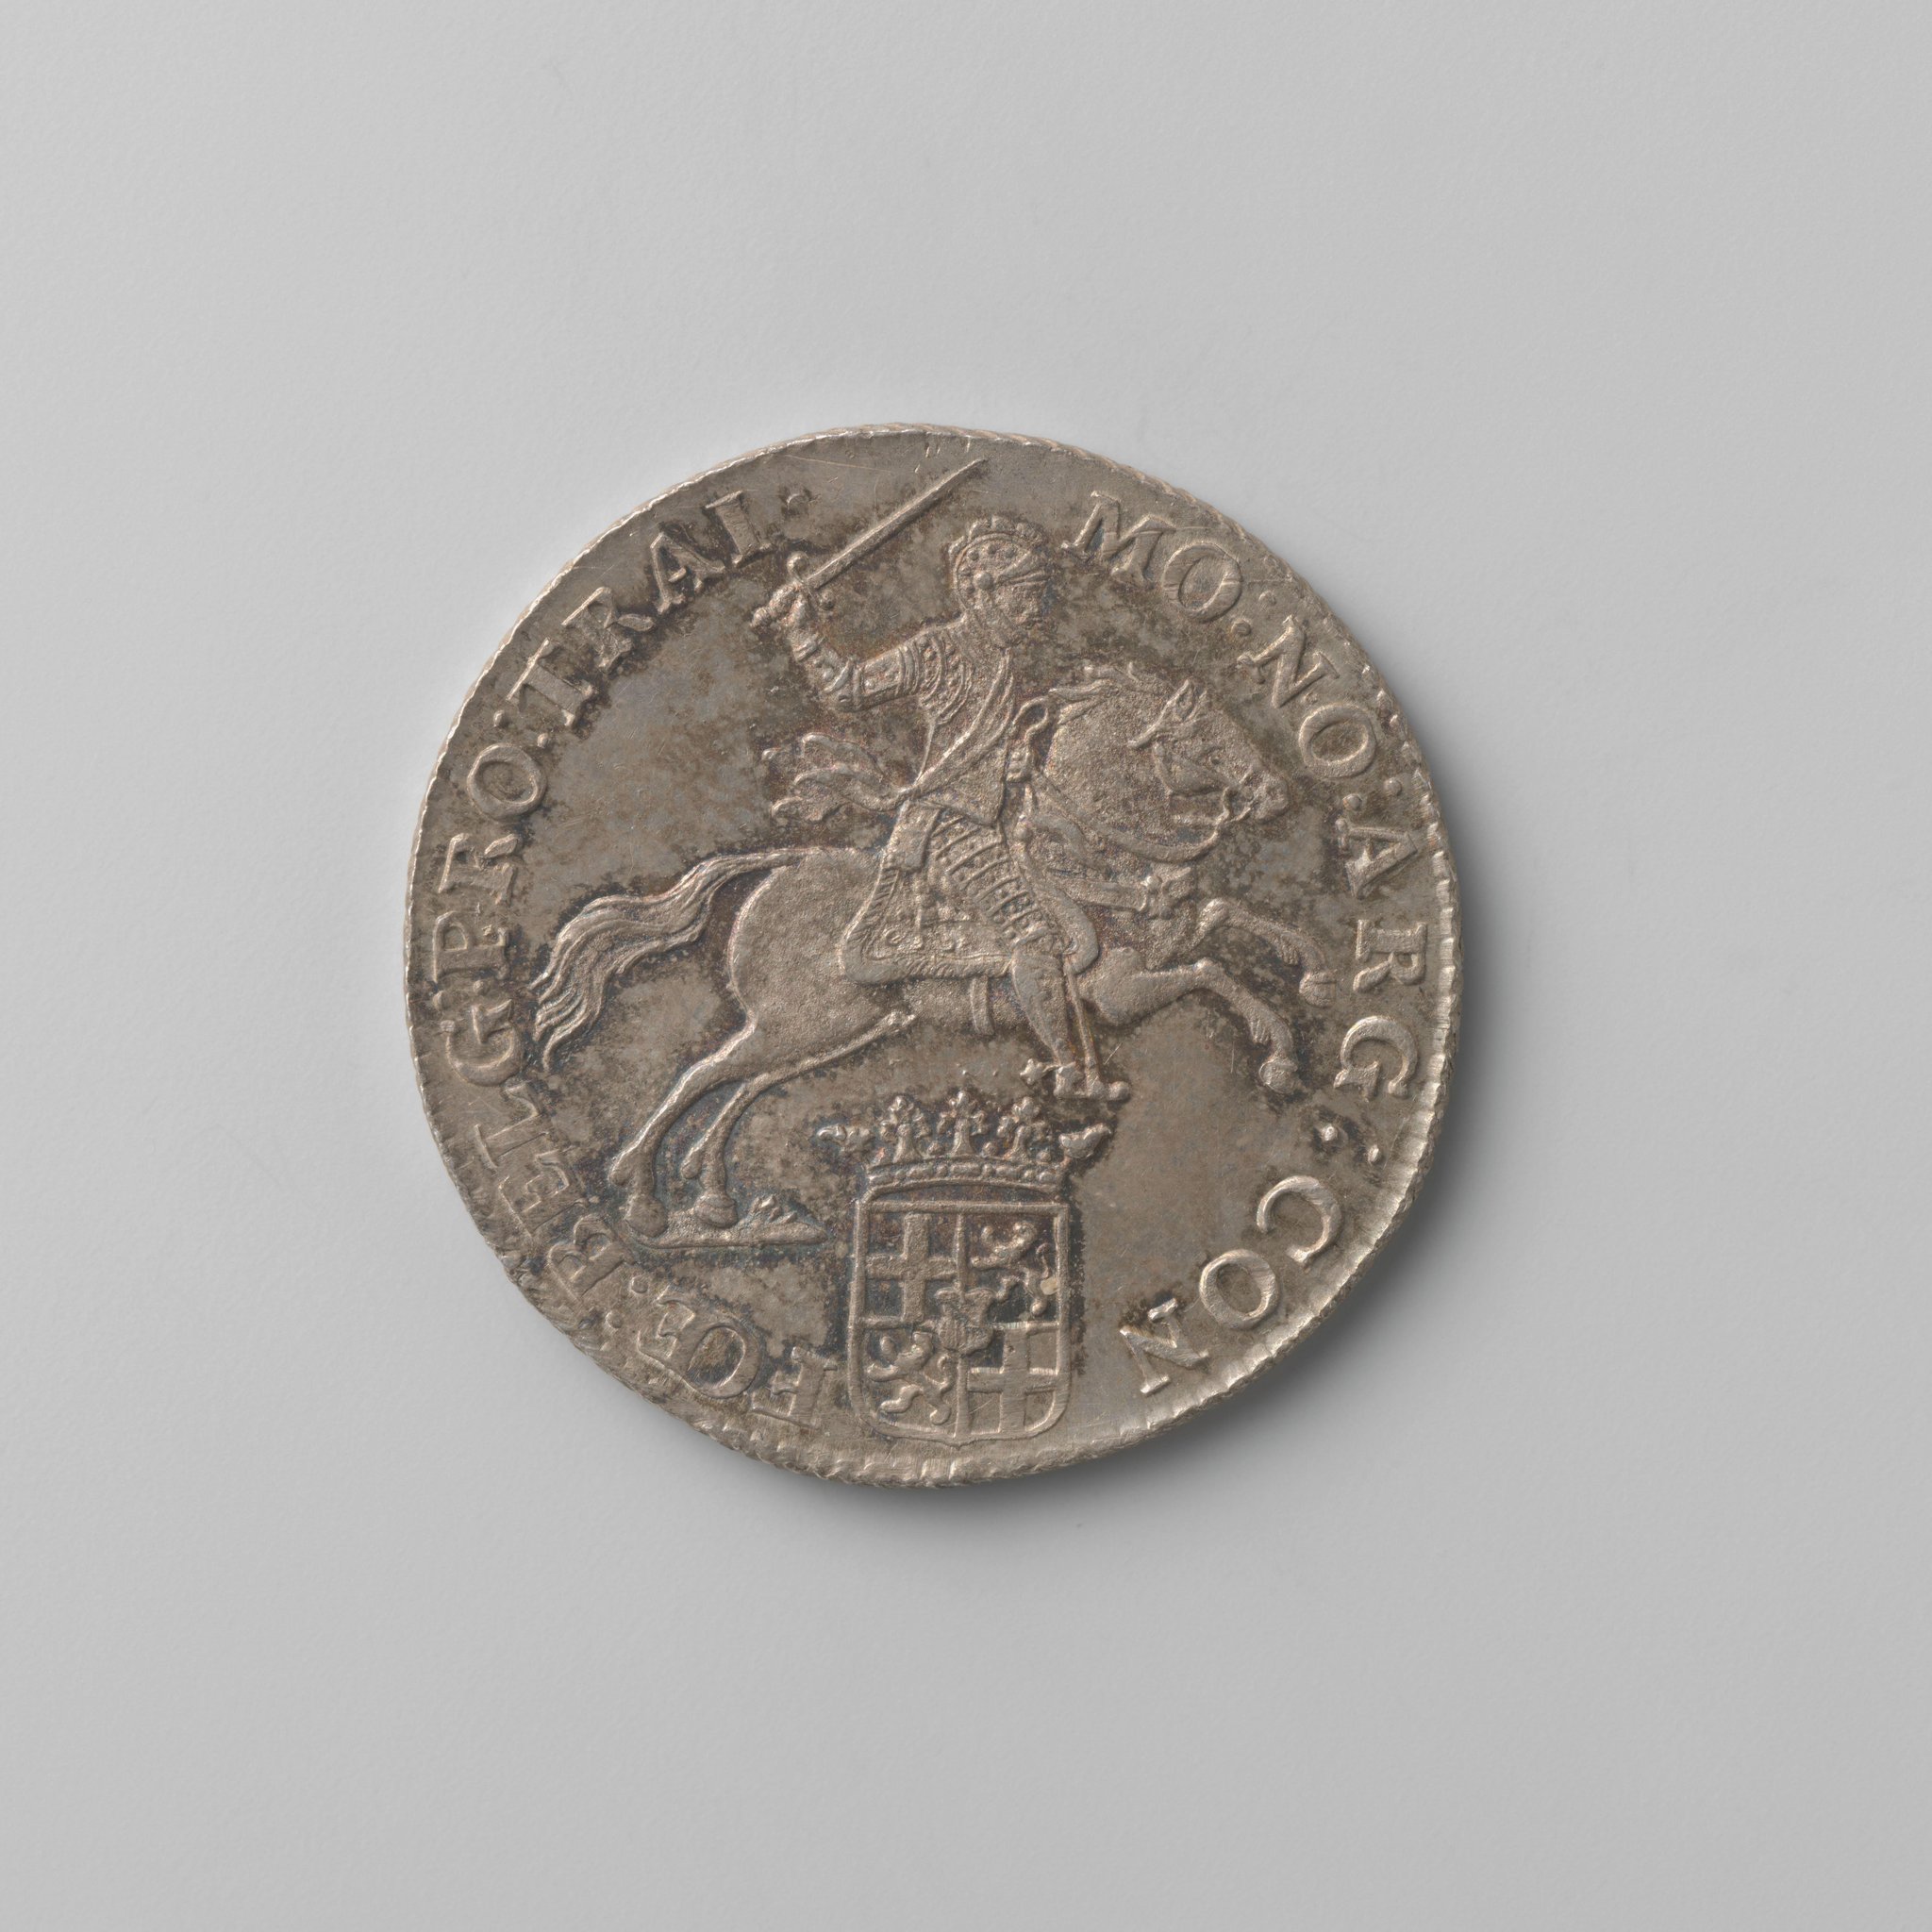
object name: coin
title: Utrecht, halve zilveren rijder, 1780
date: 1780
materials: silver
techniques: striking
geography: utrecht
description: Zilveren munt. Voorzijde: ridder te paard naar rechts met in rechterhand zwaard. Onder paard gekroond wapenschild van Utrecht. Keerzijde: door twee gekroonde leeuwen gehouden generaliteitswapenschild. Daaronder in cartouche jaartal. Kabelrand.